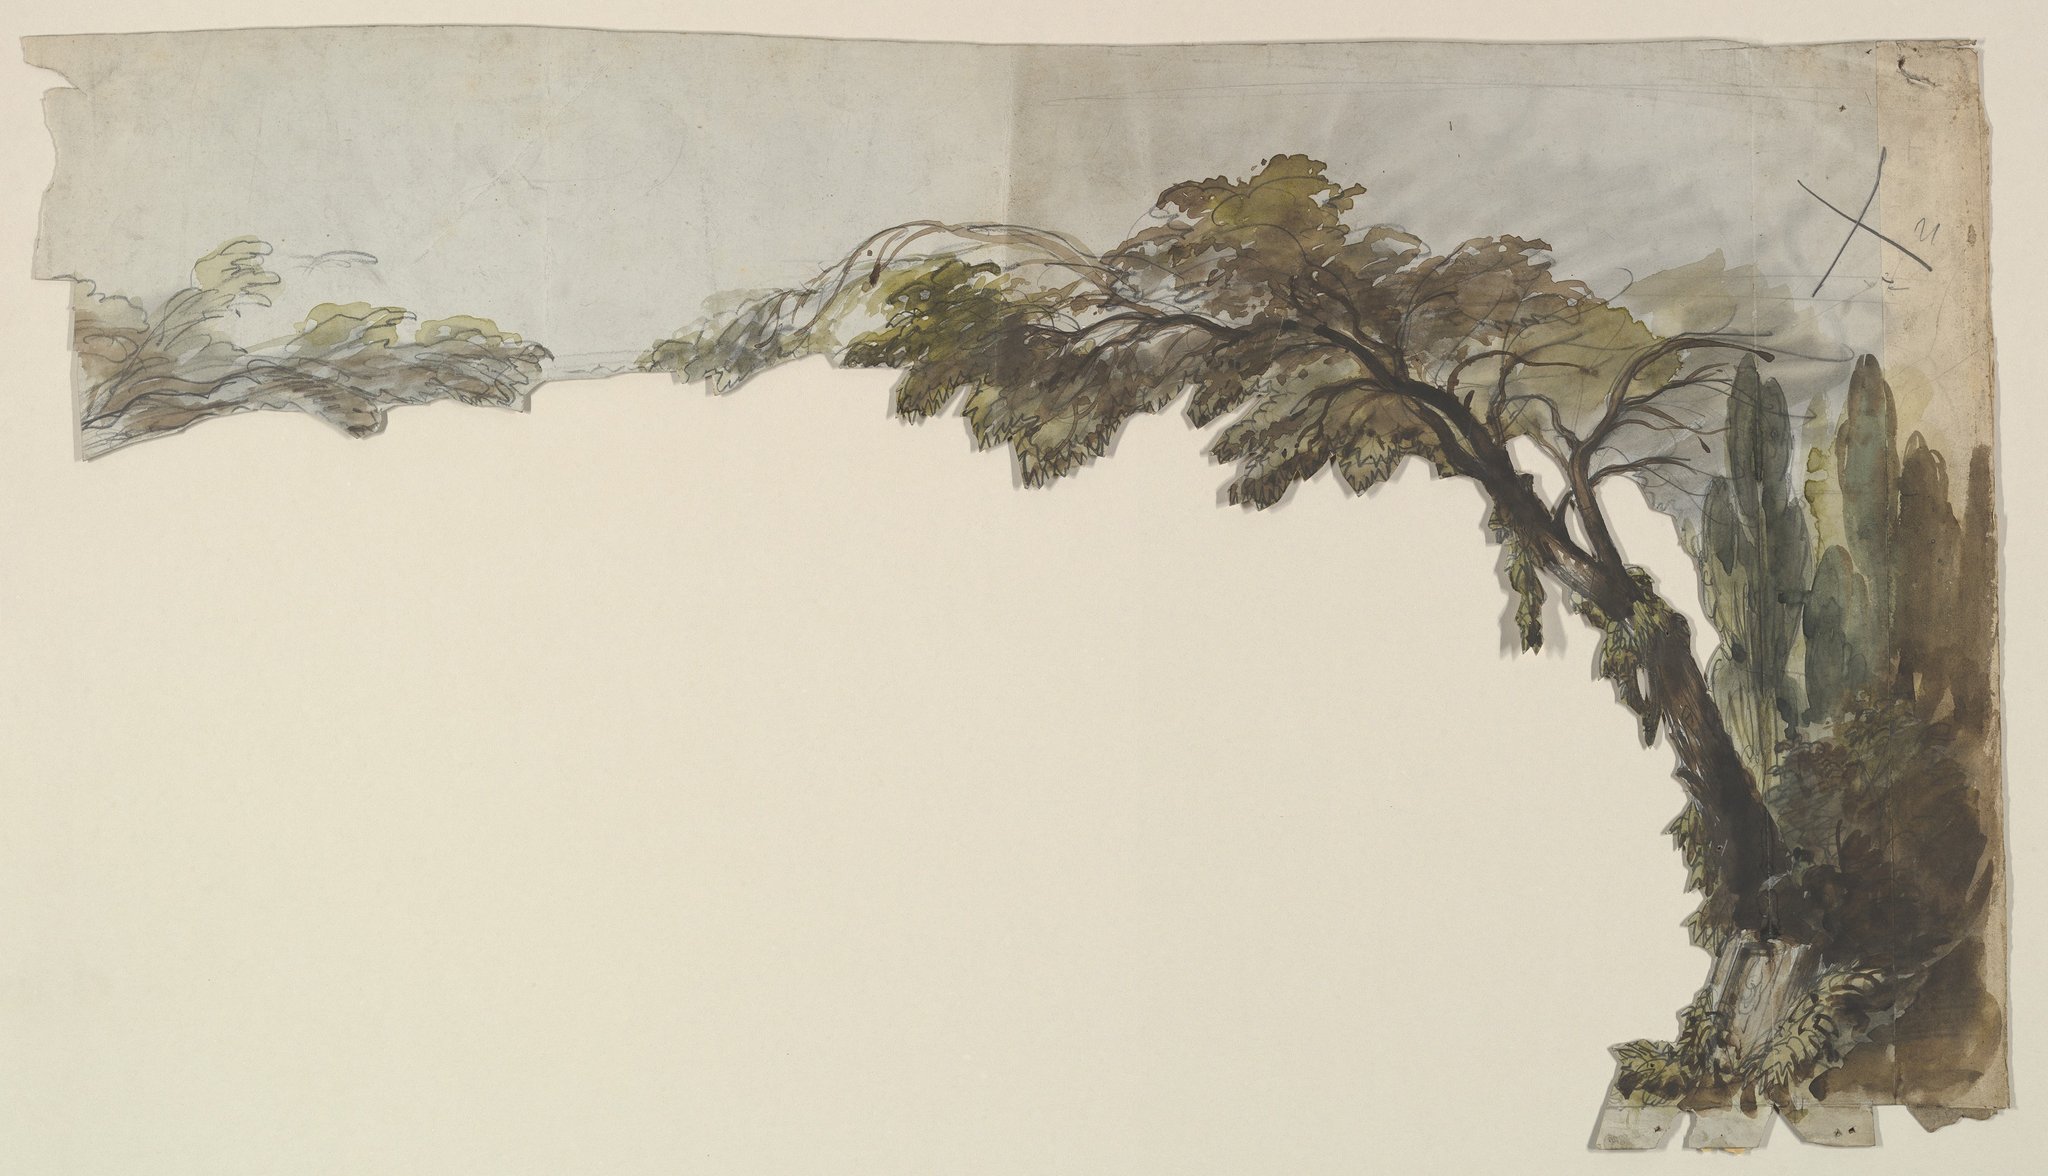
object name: drawing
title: Design for a Stage Set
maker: eugène cicéri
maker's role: artist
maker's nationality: french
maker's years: 1813-1890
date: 1830-1890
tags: trees,stage design